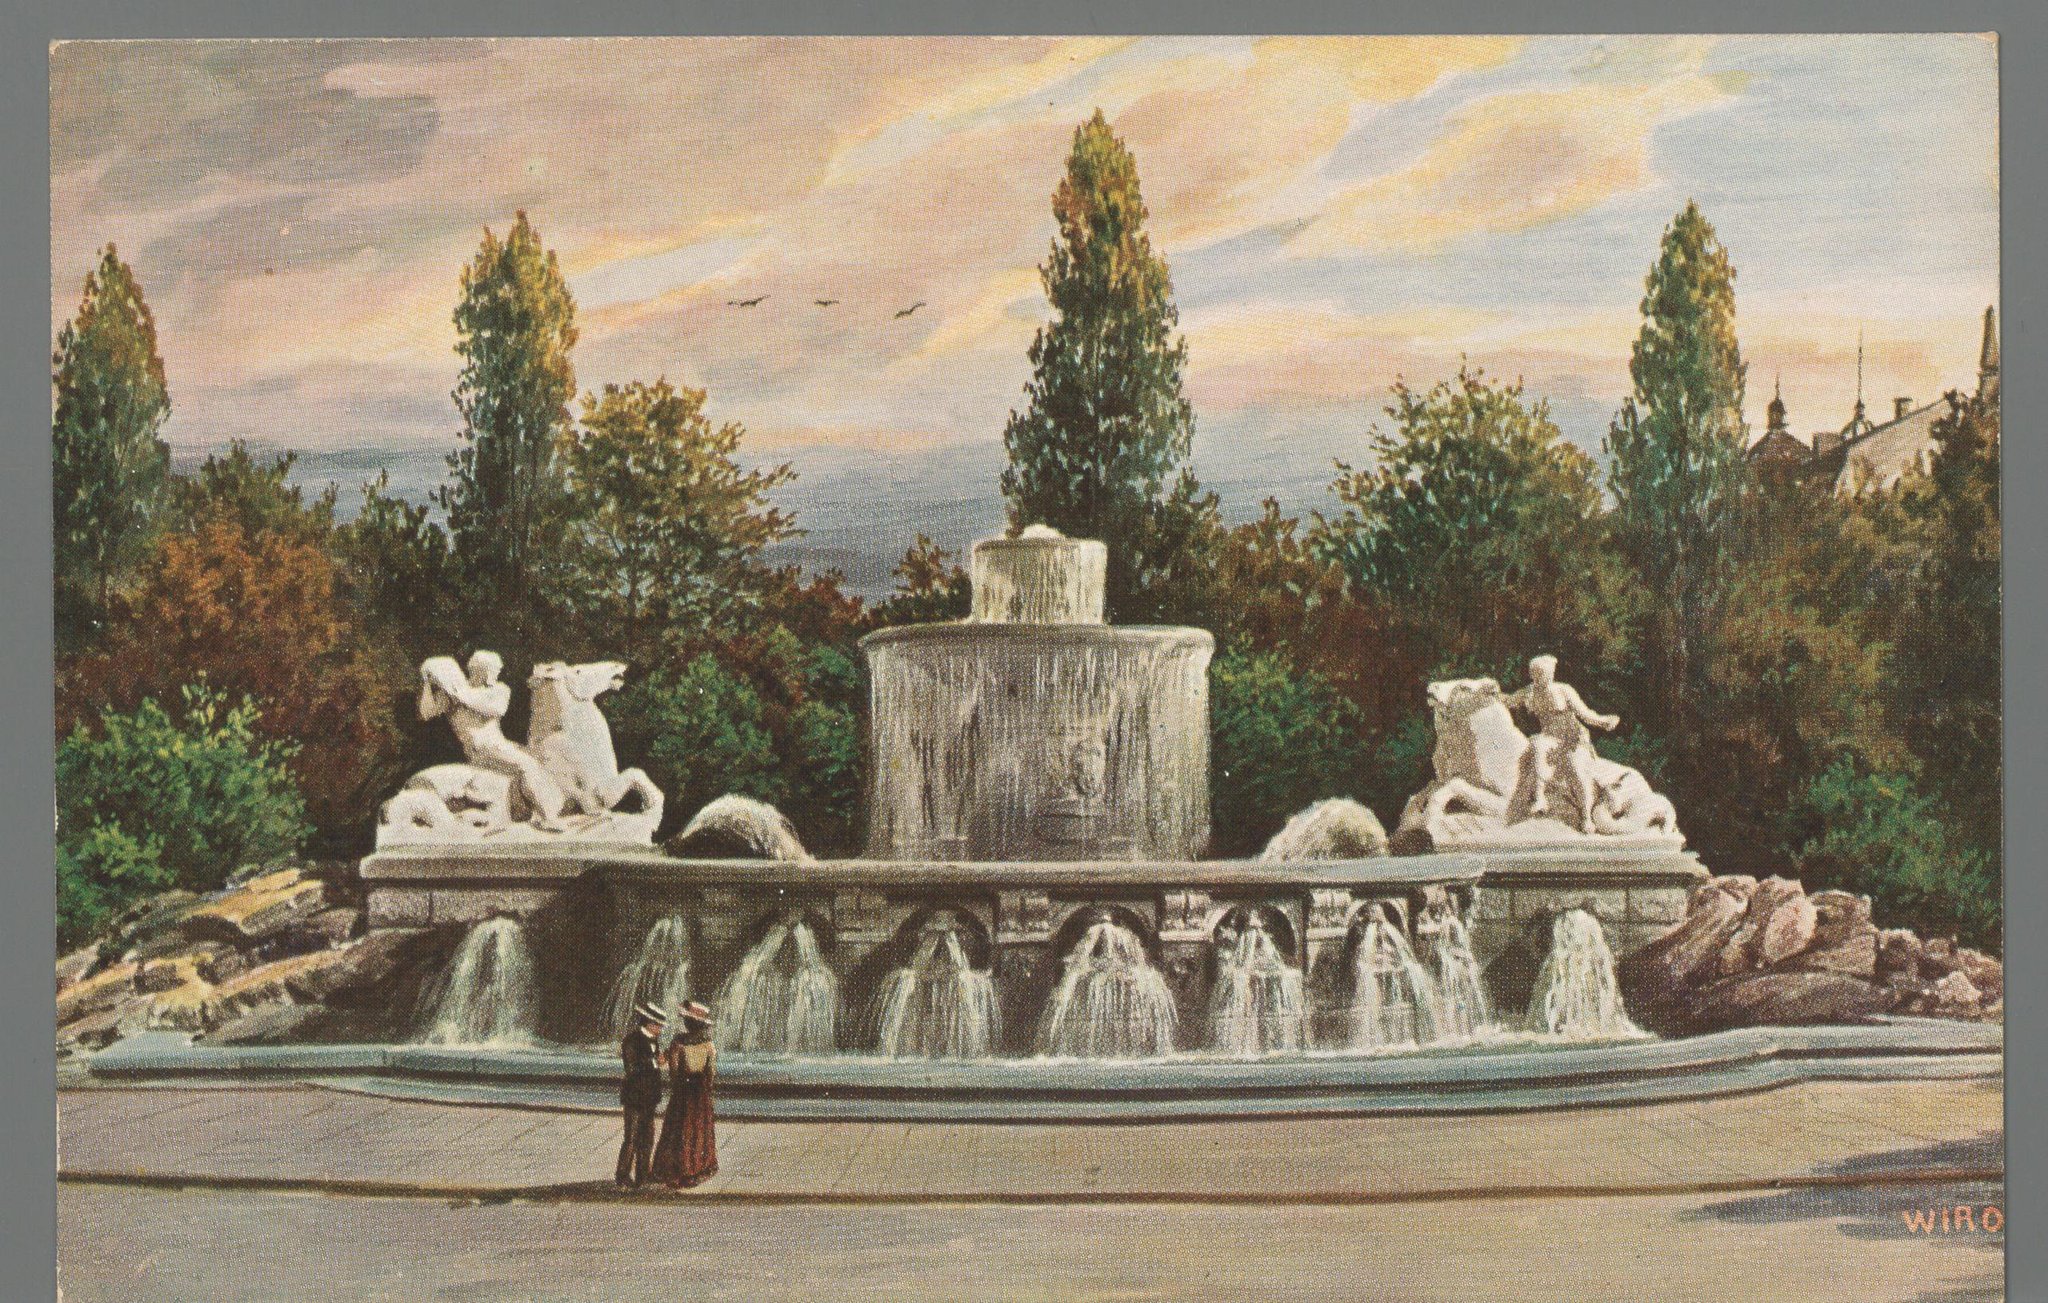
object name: ansichtkaart, prentbriefkaart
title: München, Wittelsbacherbrunnen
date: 1905-1930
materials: cardboard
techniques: color autotype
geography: roda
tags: ornamental fountain